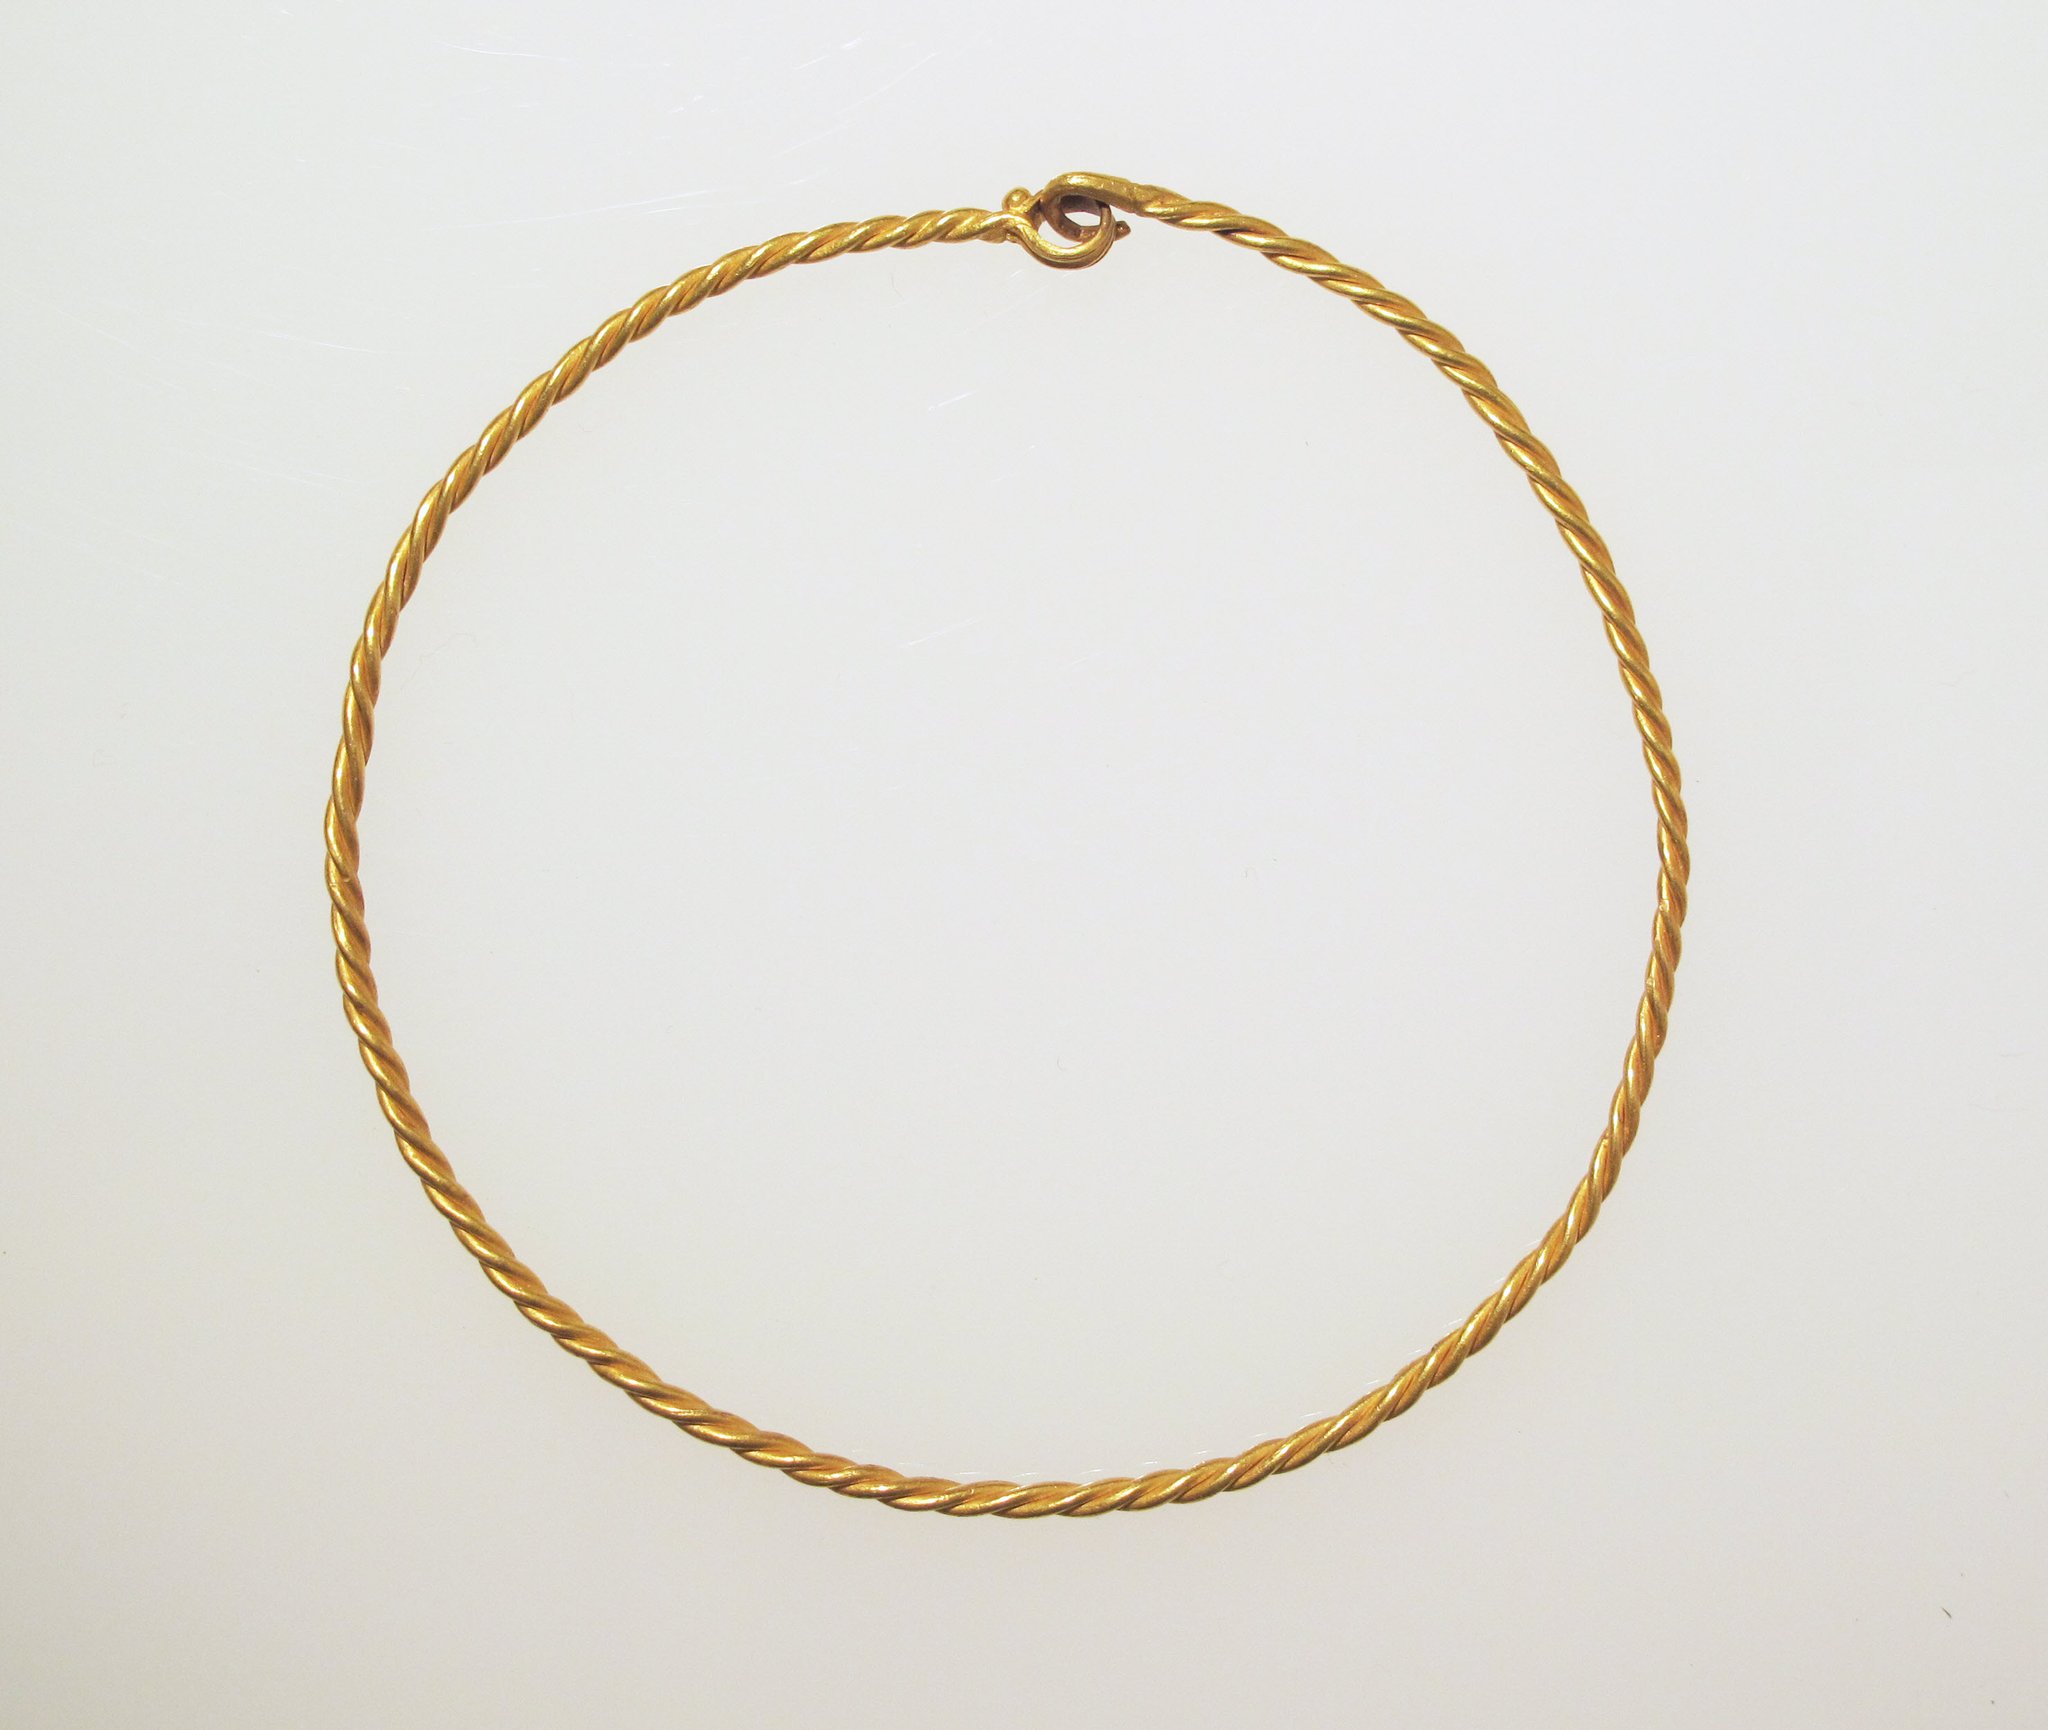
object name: bracelet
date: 7000 BCE-330 CE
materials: gold